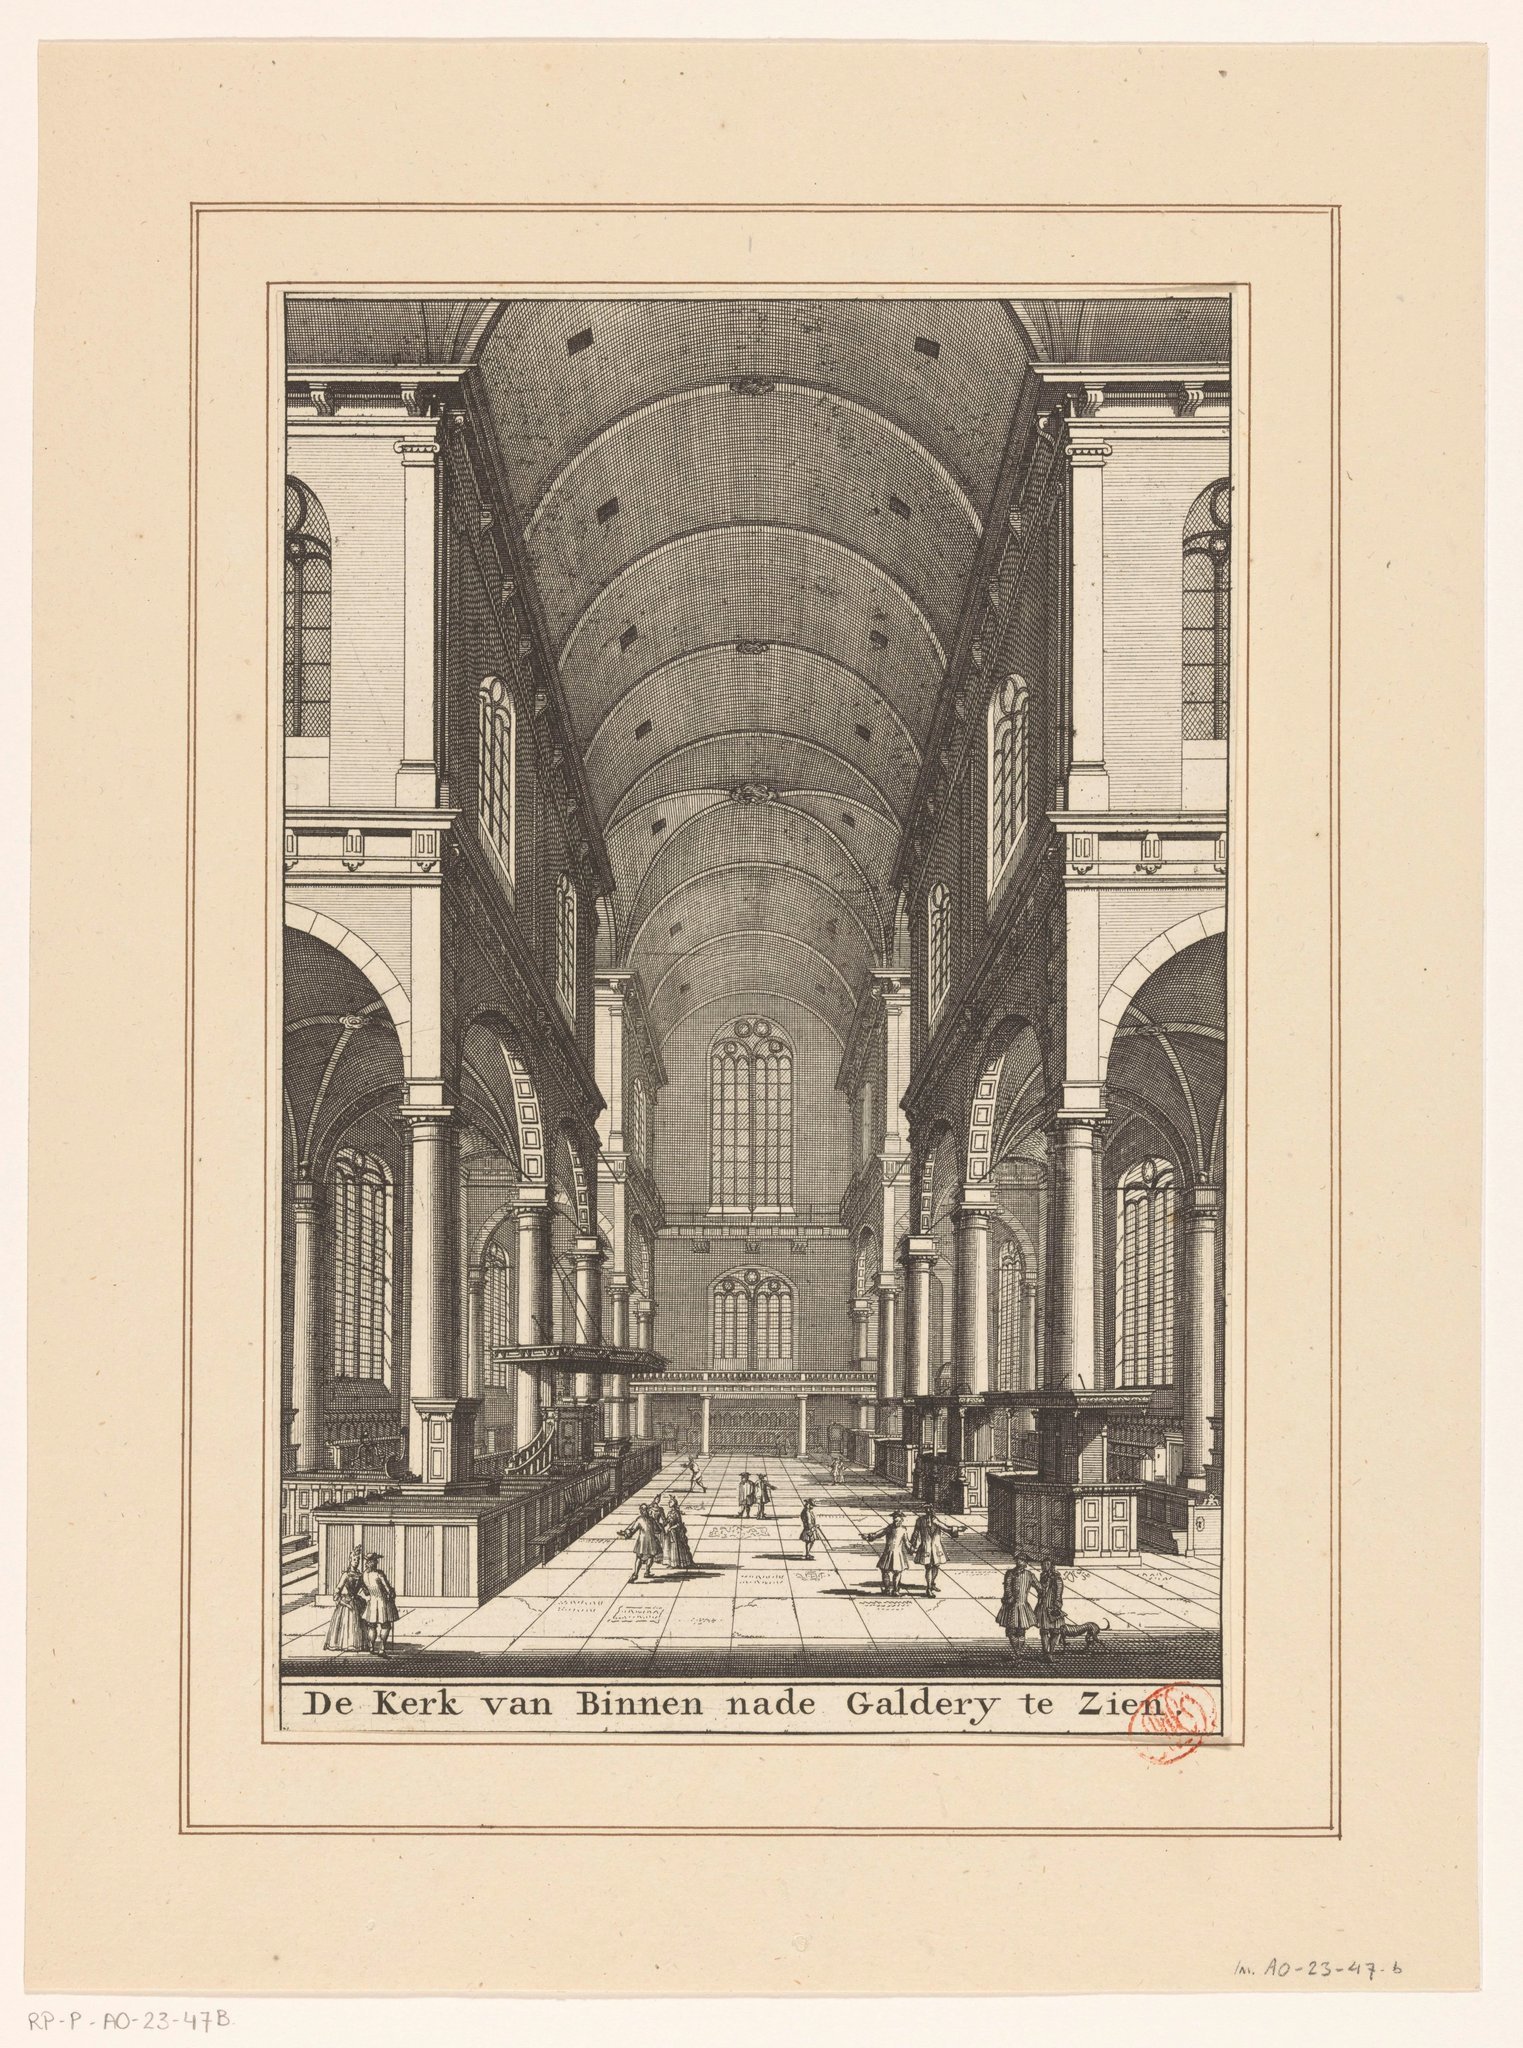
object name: print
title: De Kerk van Binnen nade Galdery te Zien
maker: daniël stopendaal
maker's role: print maker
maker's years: 1672-1726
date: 1685-1726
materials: paper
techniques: engraving, etching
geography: amsterdam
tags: interior of church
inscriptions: collector's mark: Lugt 195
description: Is waarschijnlijk oorspronkelijk één van de randprenten van 'Caart vande Sitplaat-sen inde Wester-Kerk', een plattegrond van de zitplaatsen in de Westerkerk. Daniël Stopendaal staat als prentmaker vermeld op de plattegrond zelf, de randprenten zijn mogelijk ook door hem gemaakt. Zie RP-P-AO-23-46-1, RP-P-AO-23-46-2 en RP-P-AO-23-47A voor andere bijhorende randprenten. Zie RP-P-AO-23-57 voor een soortgelijke plattegrond van de Oosterkerk met randprenten.